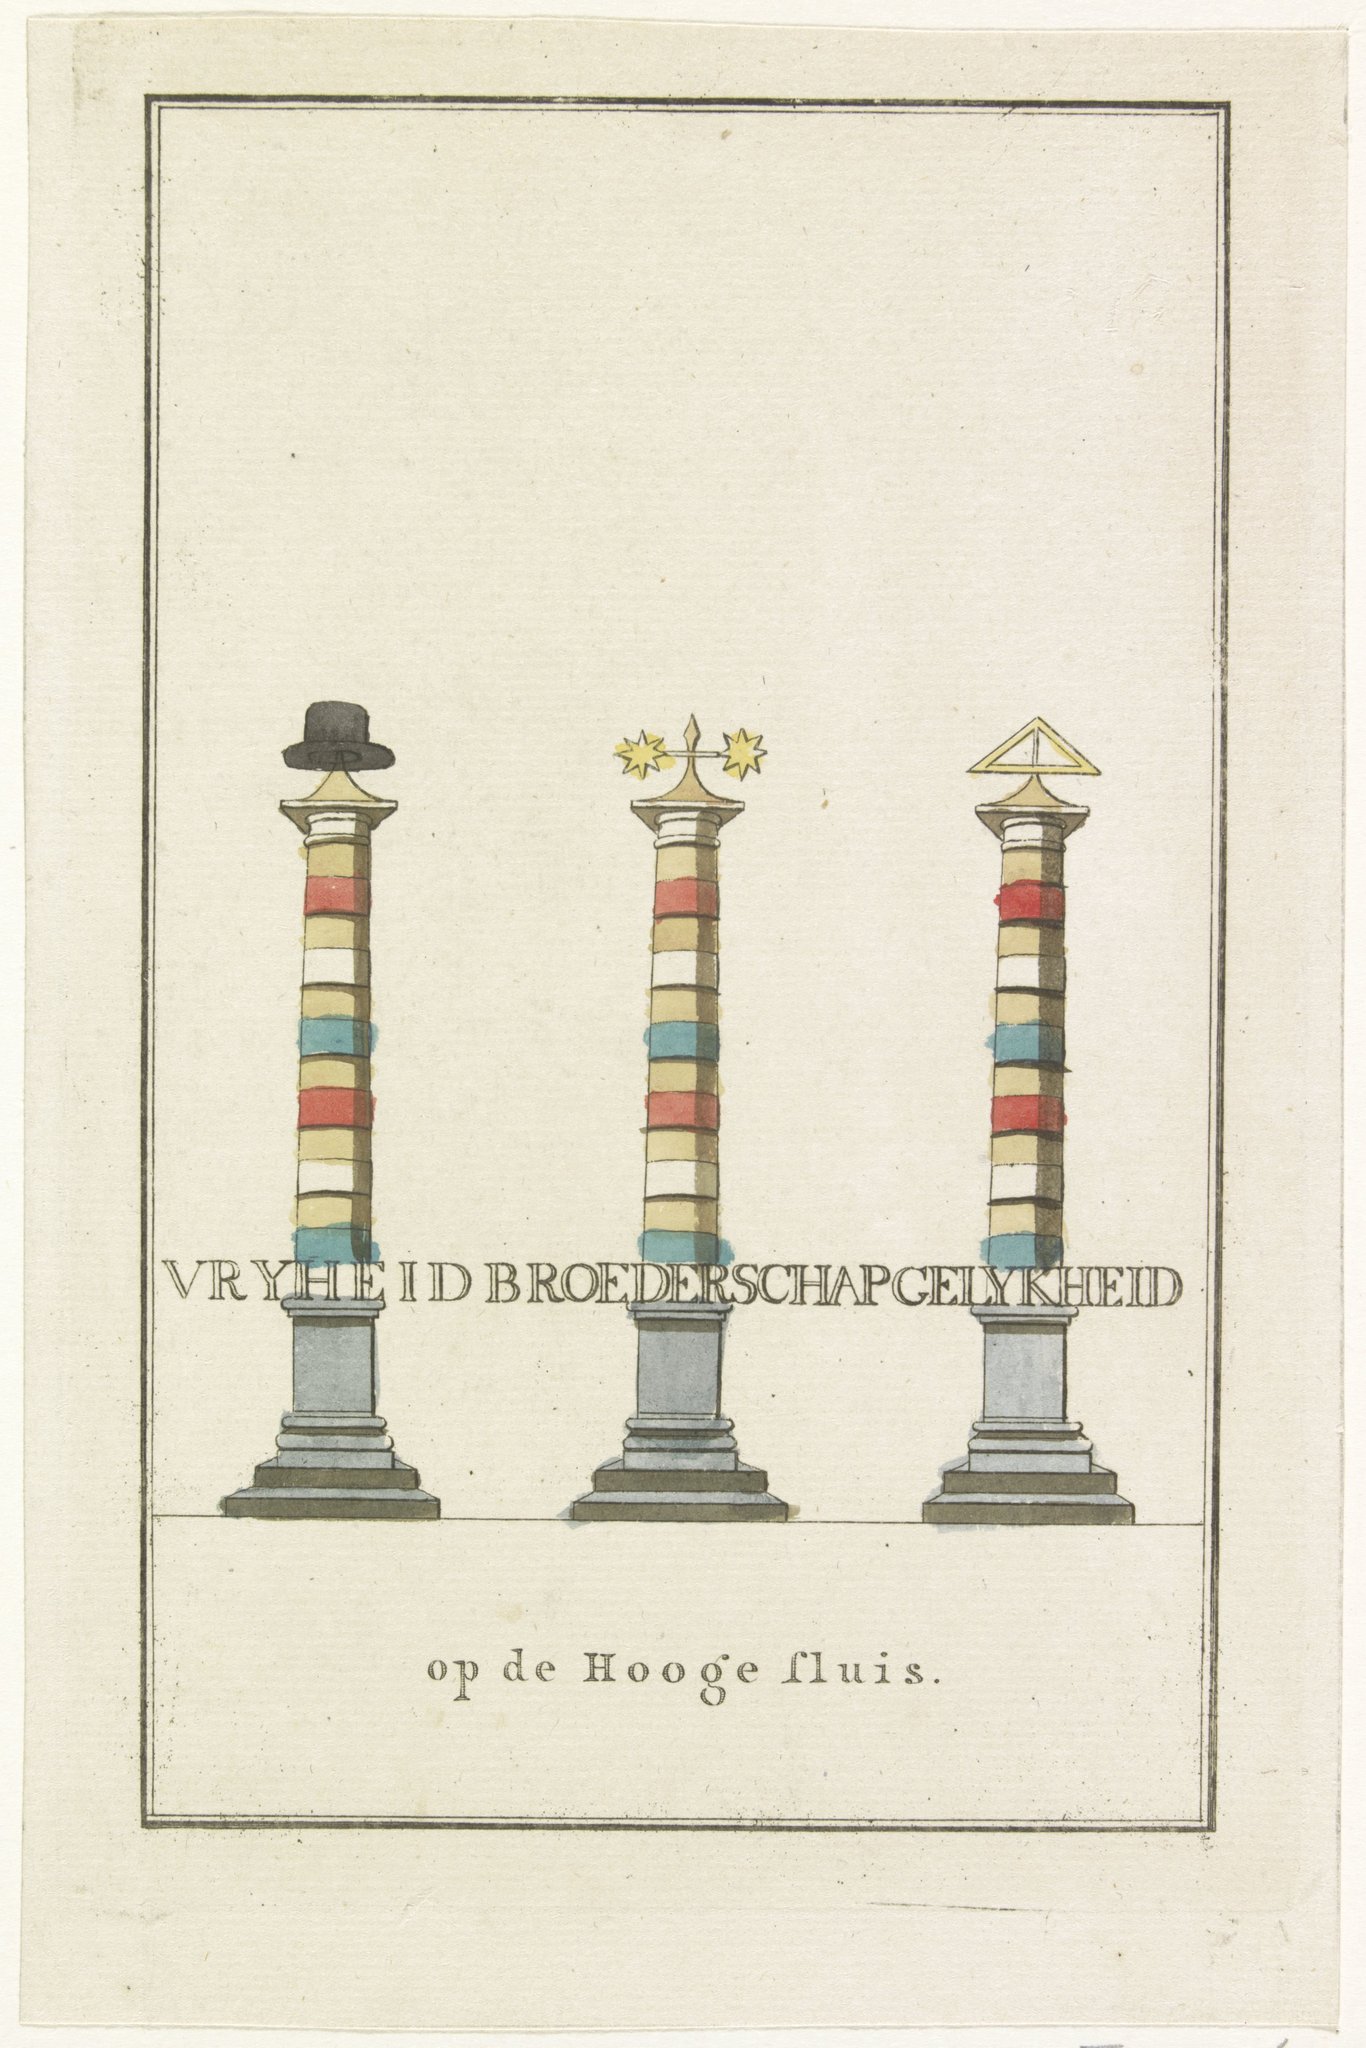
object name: print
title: Vrijheid, Broederschap en Gelijkheid, decoratie op de Hogesluis, 1795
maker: noach van der meer (ii)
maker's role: draughtsman, print maker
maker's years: 1741-1822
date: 1795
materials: paper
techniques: etching, hand coloring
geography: netherlands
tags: festivities on events of national importance (+ festive decoration ~ festive activities), amsterdam, alliance with france (1795)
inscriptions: collector's mark: Lugt 2228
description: Drie zuilen voor Vrijheid, Broederschap en Gelijkheid, allegorische decoratie opgericht op de Hogesluis aan de Amstel te Amsterdam. Uit het boekje met afbeeldingen van de versieringen opgericht in de stad bij de viering van de installatie van de representanten en de alliantie gesloten tussen de Franse en de Bataafse Republiek, 19 juni 1795.